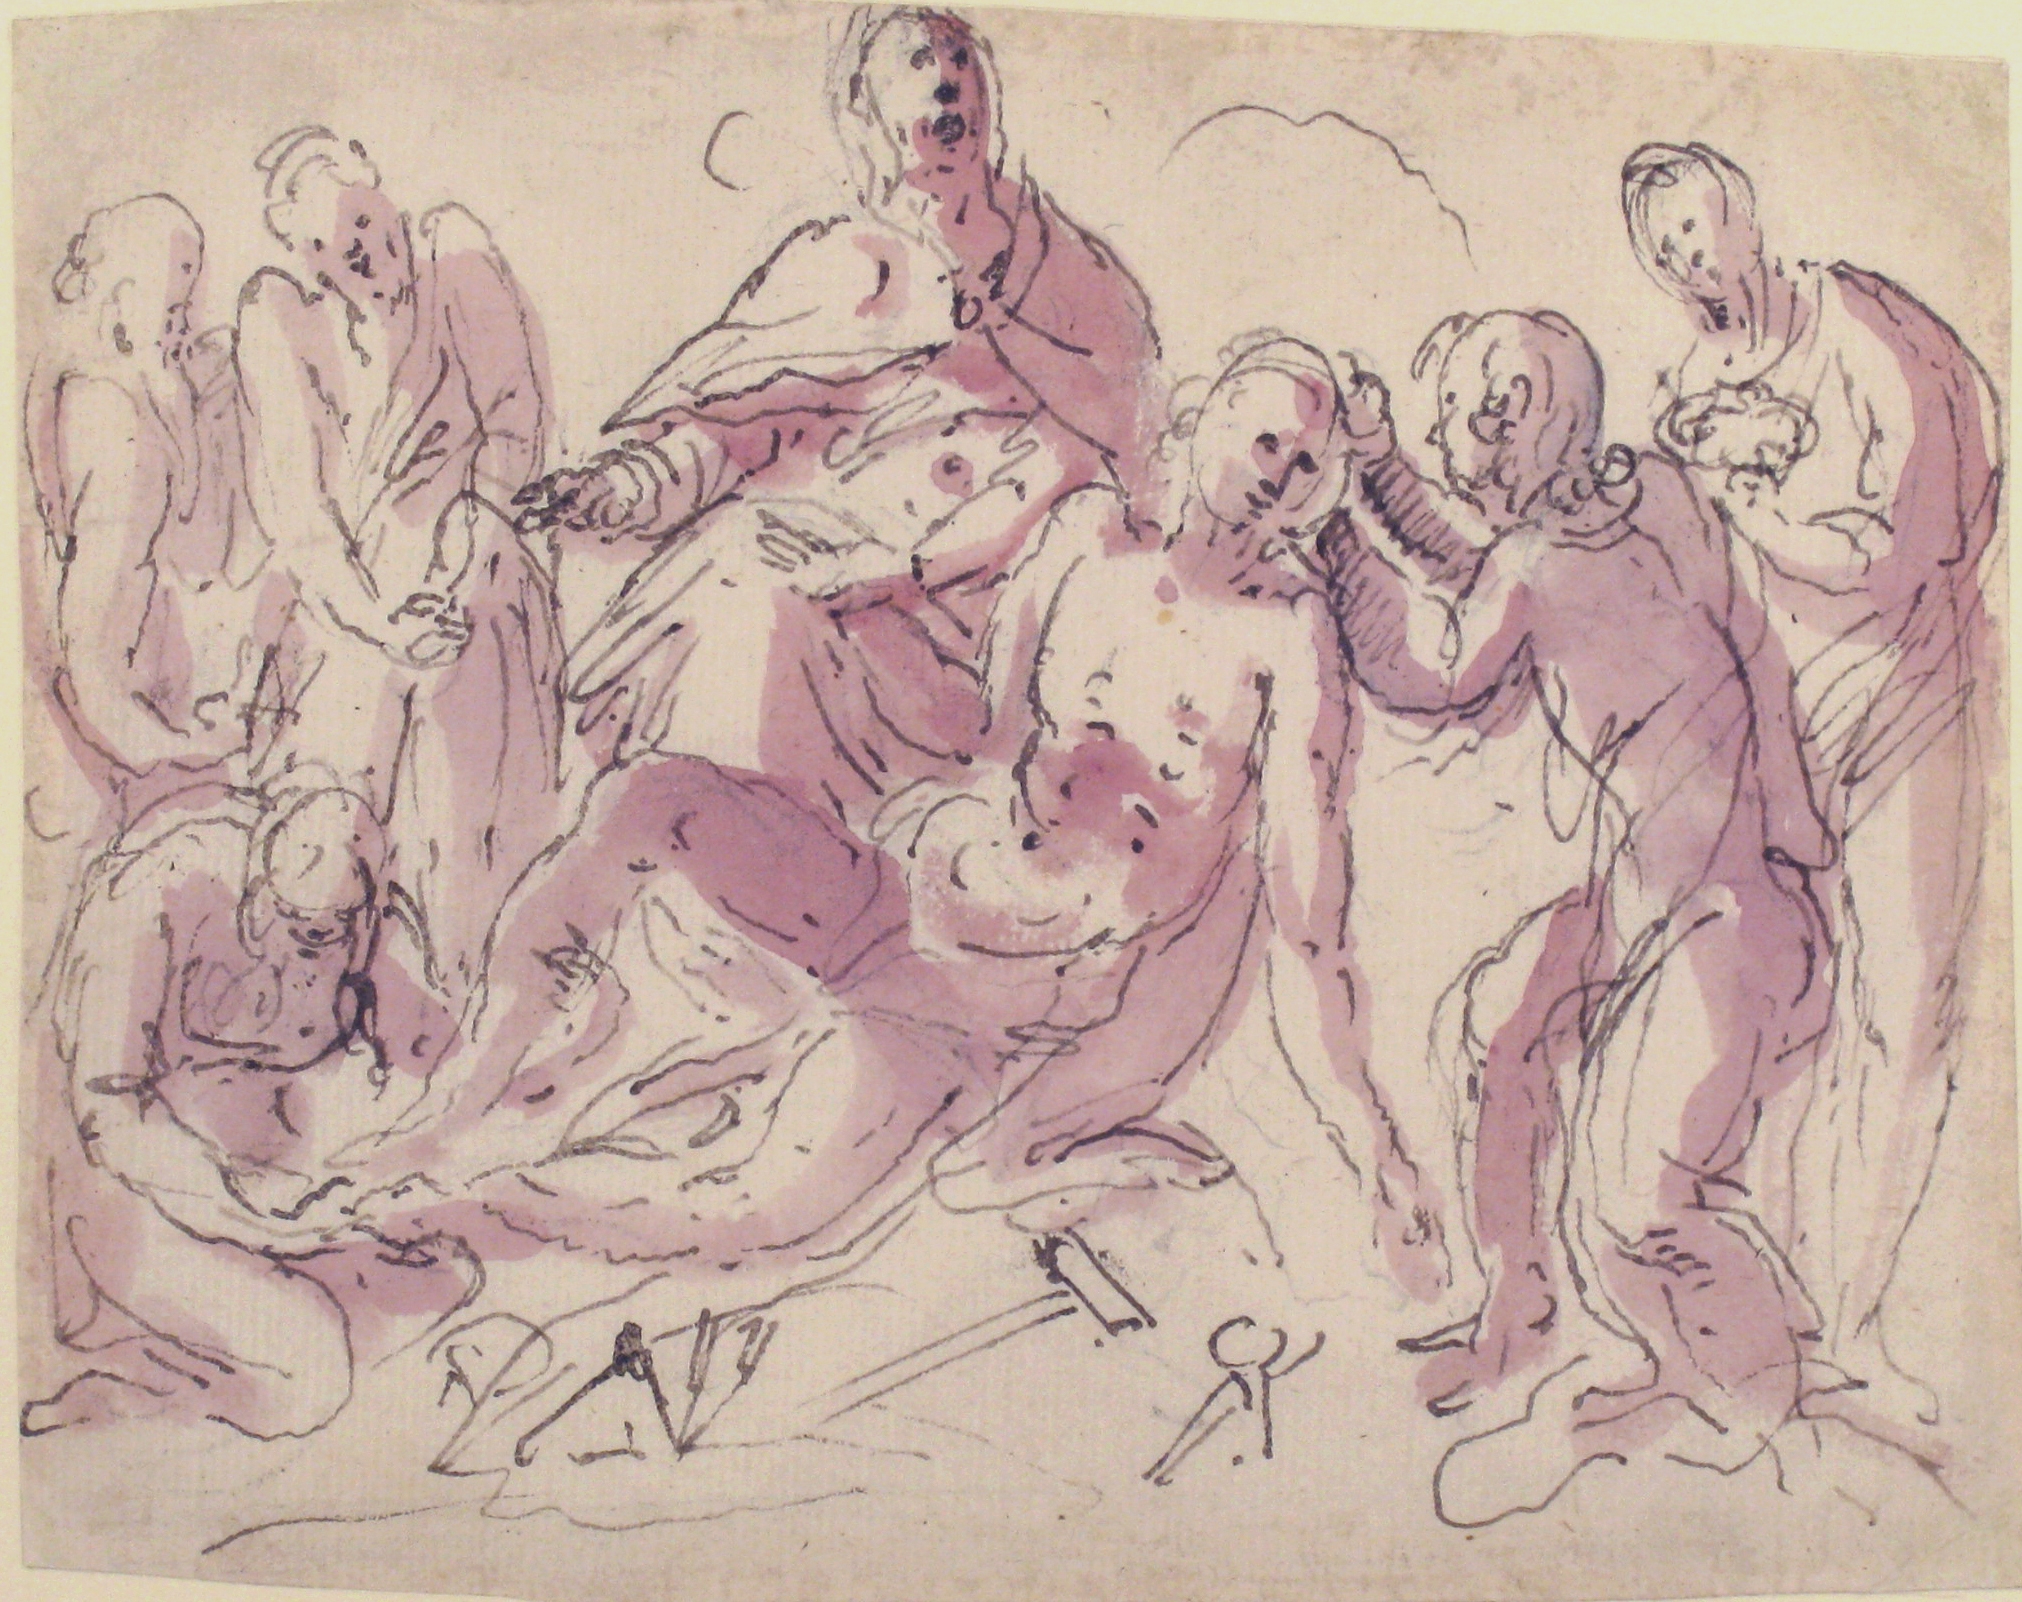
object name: drawing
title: Lamentation over the Dead Christ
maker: francesco curia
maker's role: artist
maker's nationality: italian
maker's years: 1565-1608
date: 1565-1608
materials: chalk, ink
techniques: brush, pen, wash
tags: christ,lamentation